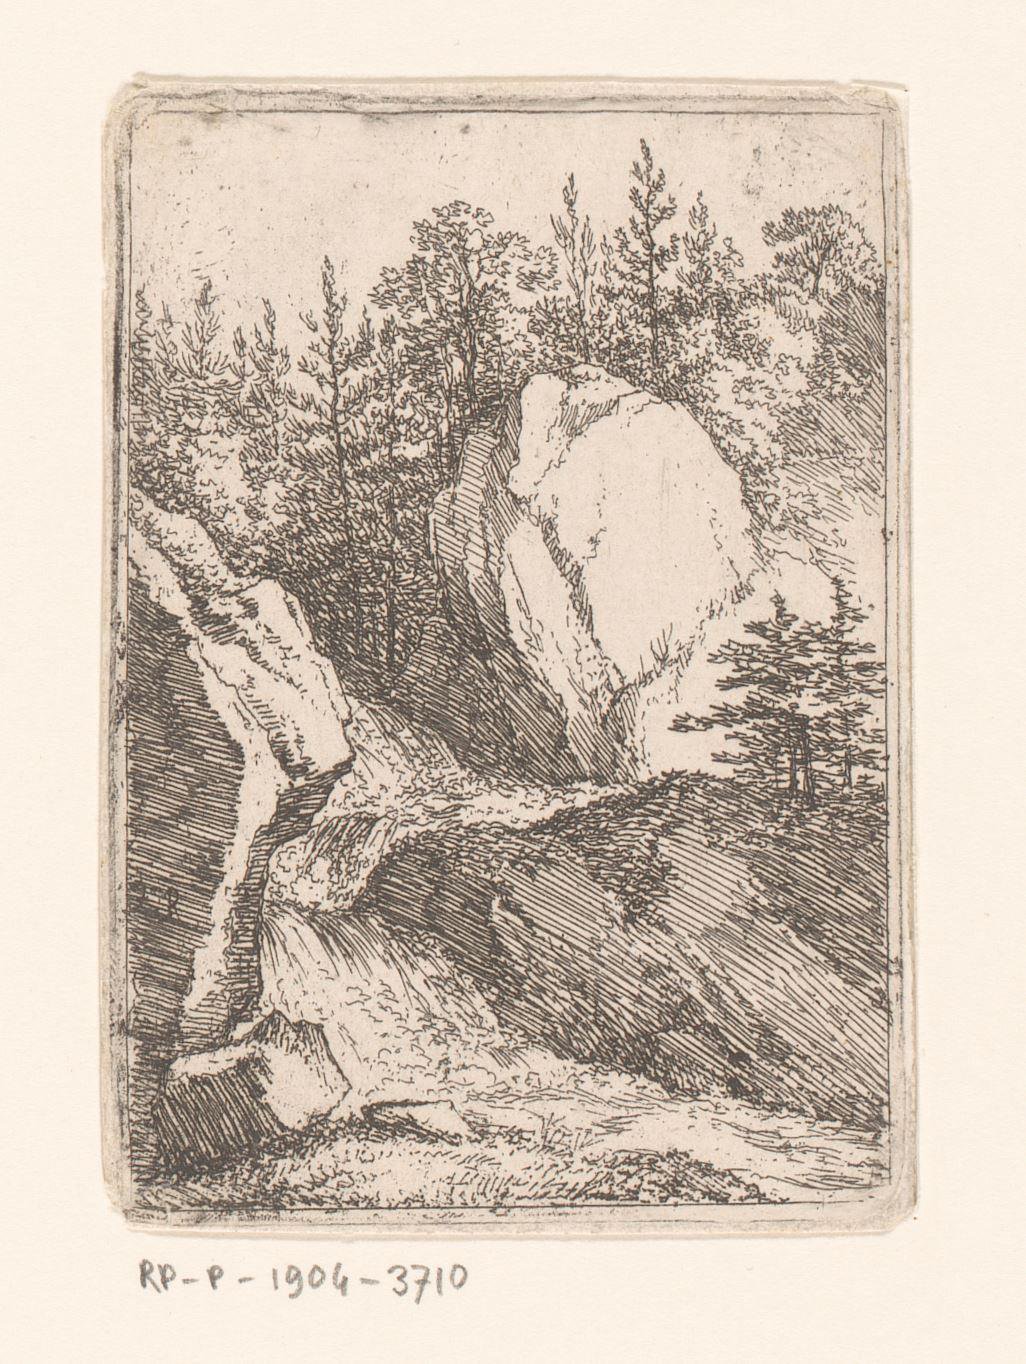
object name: print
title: Landschap met een beek tussen rotsen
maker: sauveur legros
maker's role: print maker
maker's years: 1754-1834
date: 1764-1834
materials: paper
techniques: etching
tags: brook, rocks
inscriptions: collector's mark: Lugt 2228